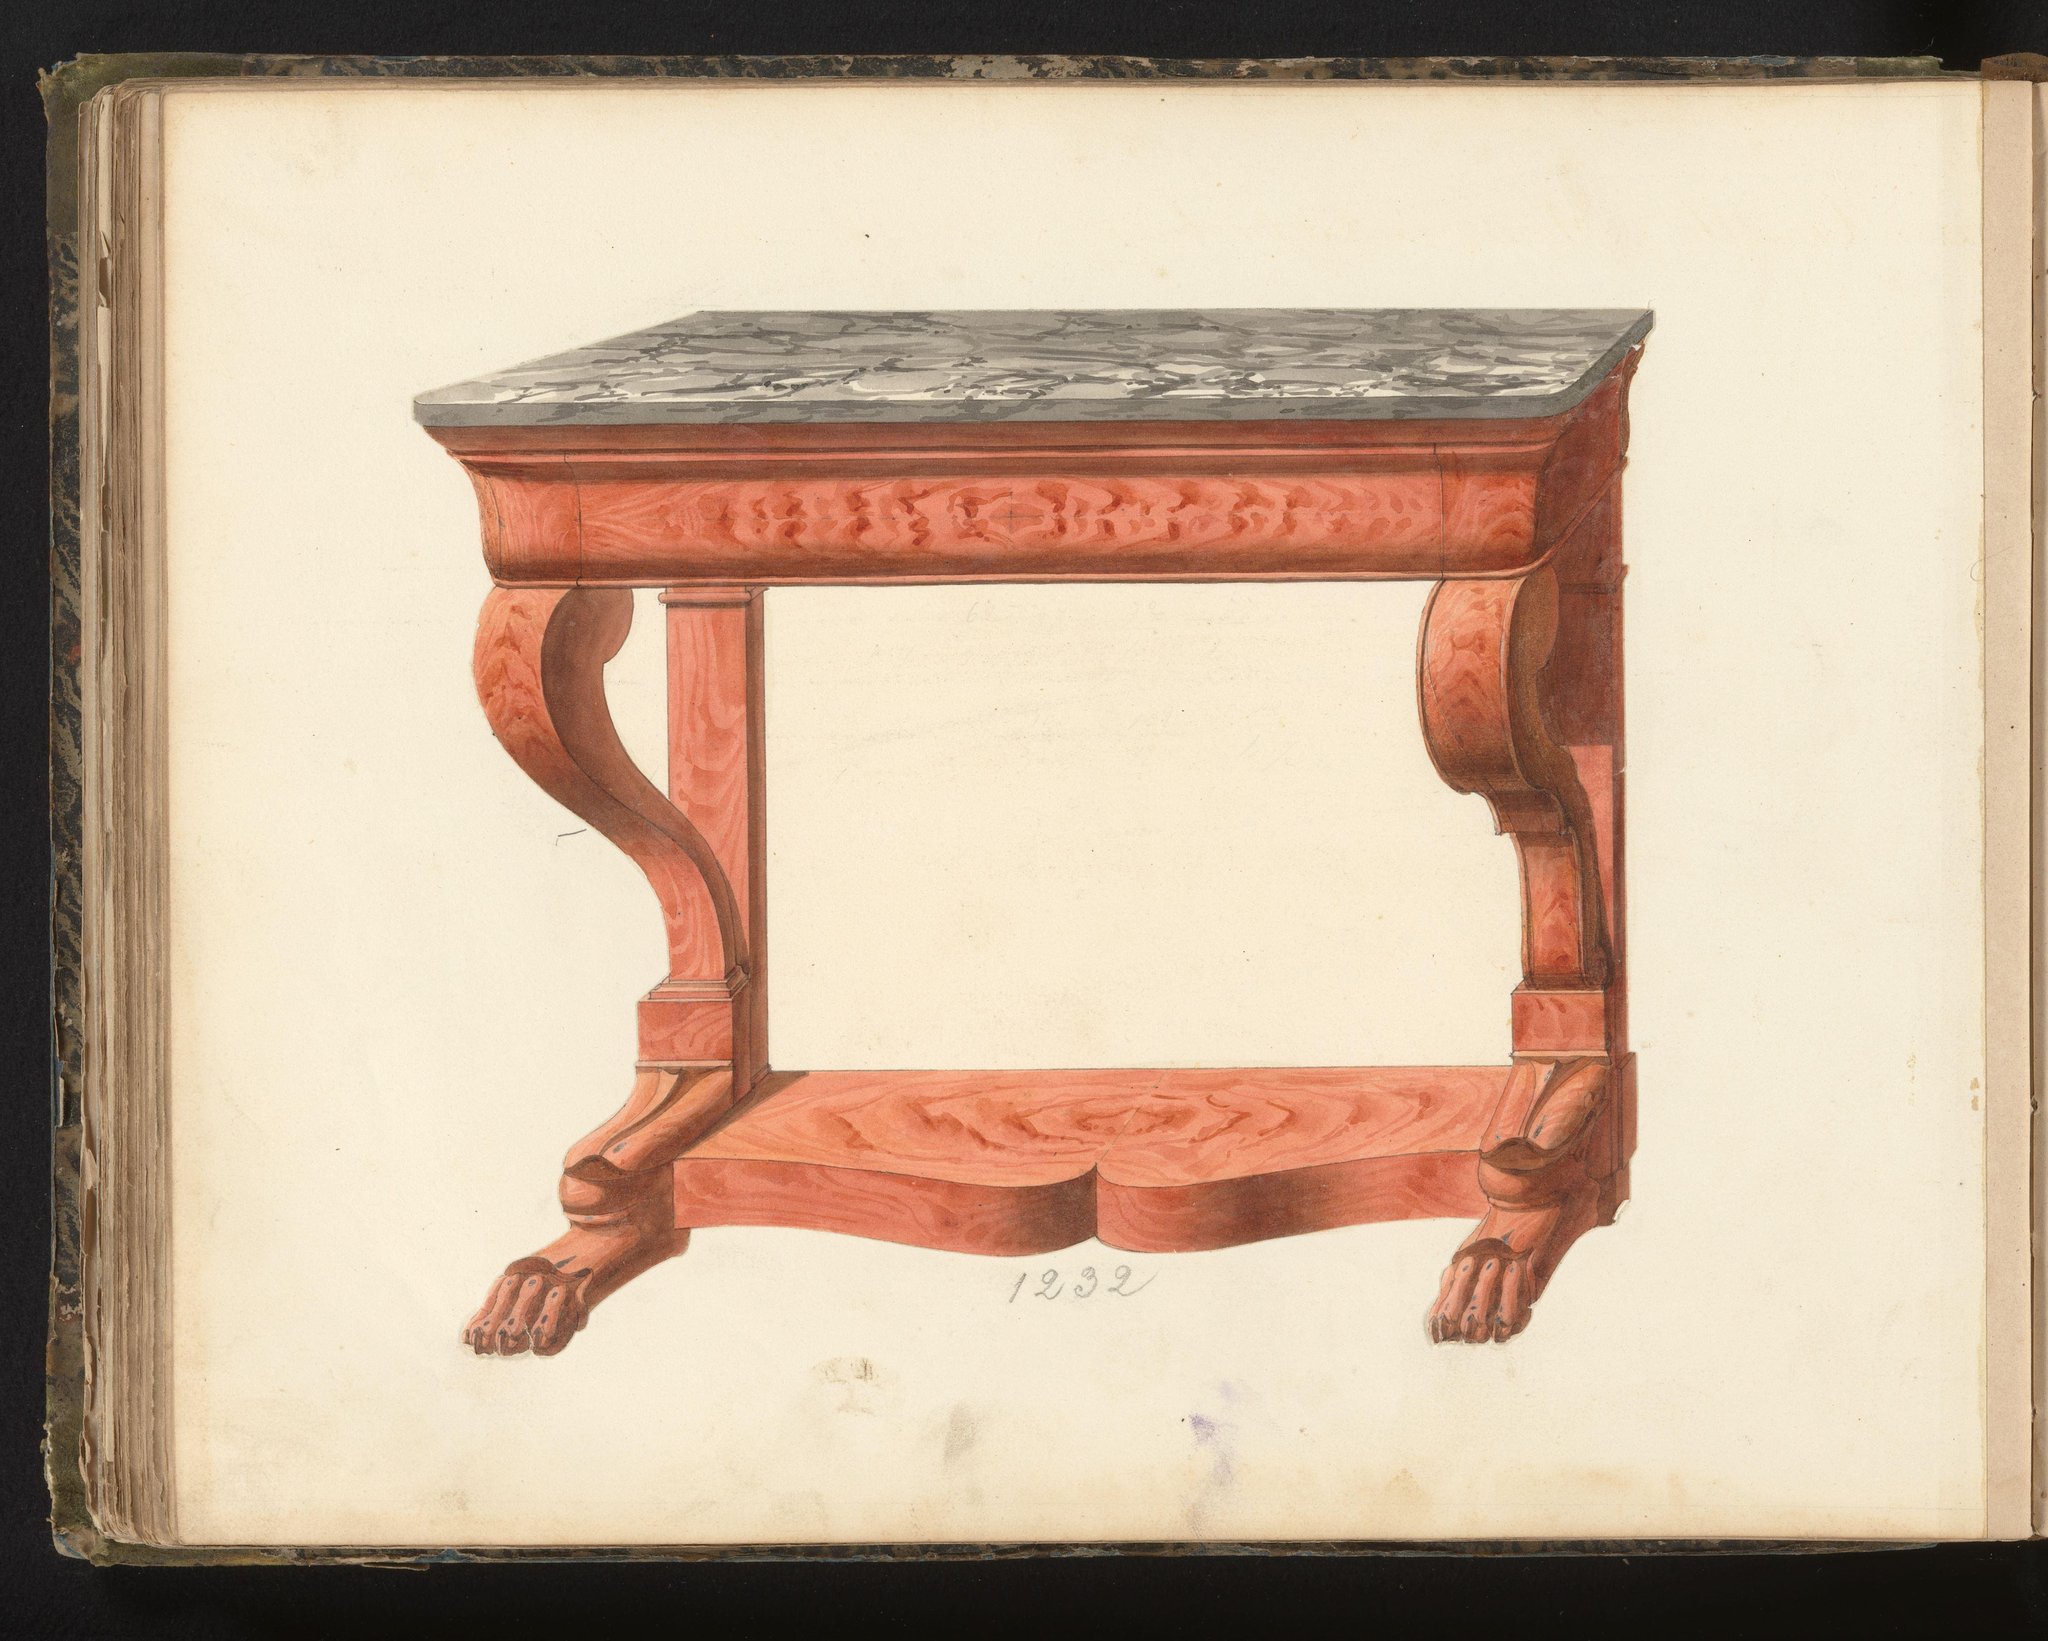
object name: album leaf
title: Ontwerp voor een wandtafel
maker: Anonymous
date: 1825-1839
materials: ink, paper, pencil, watercolor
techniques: brush, pen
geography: paris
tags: table (+ wood and other phytogenic material), furniture to put things on (+ stone)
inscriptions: inscription: ‘1232 Consolle à jaret a volutte briseé 2½ 3 3½ 4’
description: Ontwerp voor een wandtafel (a jarret = dierenvoet) met marmeren blad steunend op voluten. Het blad op de achterzijde genummerd: 71, het tegenoverliggende blad met informatie over de afgebeelde meubelen genummerd: 71 bis. Onderdeel van een album met 80 bladen met tekeningen en een prent van gefineerde en gelakte meubelen, alsmede zitmeubelen.